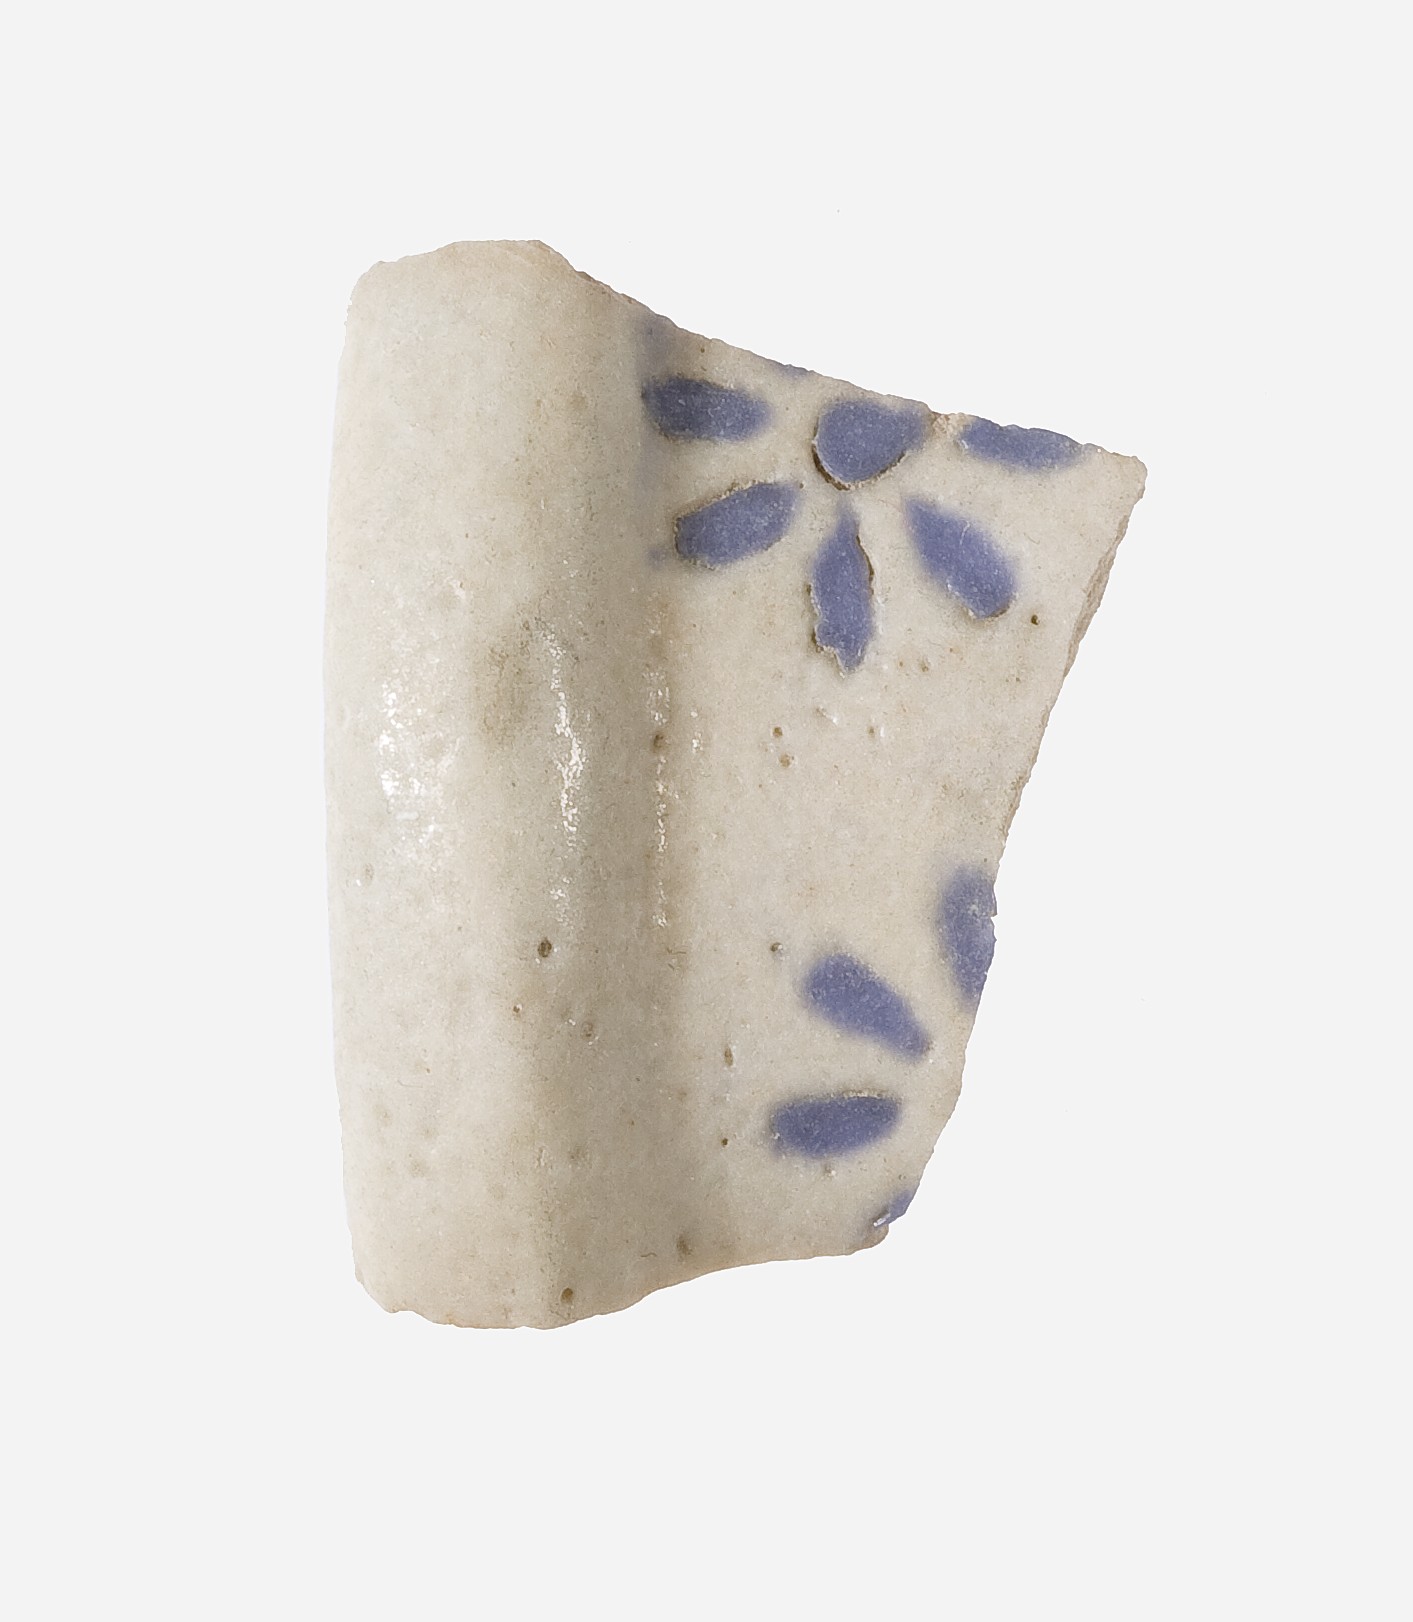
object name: jar, lip fragment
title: Fragment of a Jar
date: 1390-1352 BCE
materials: faience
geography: egypt